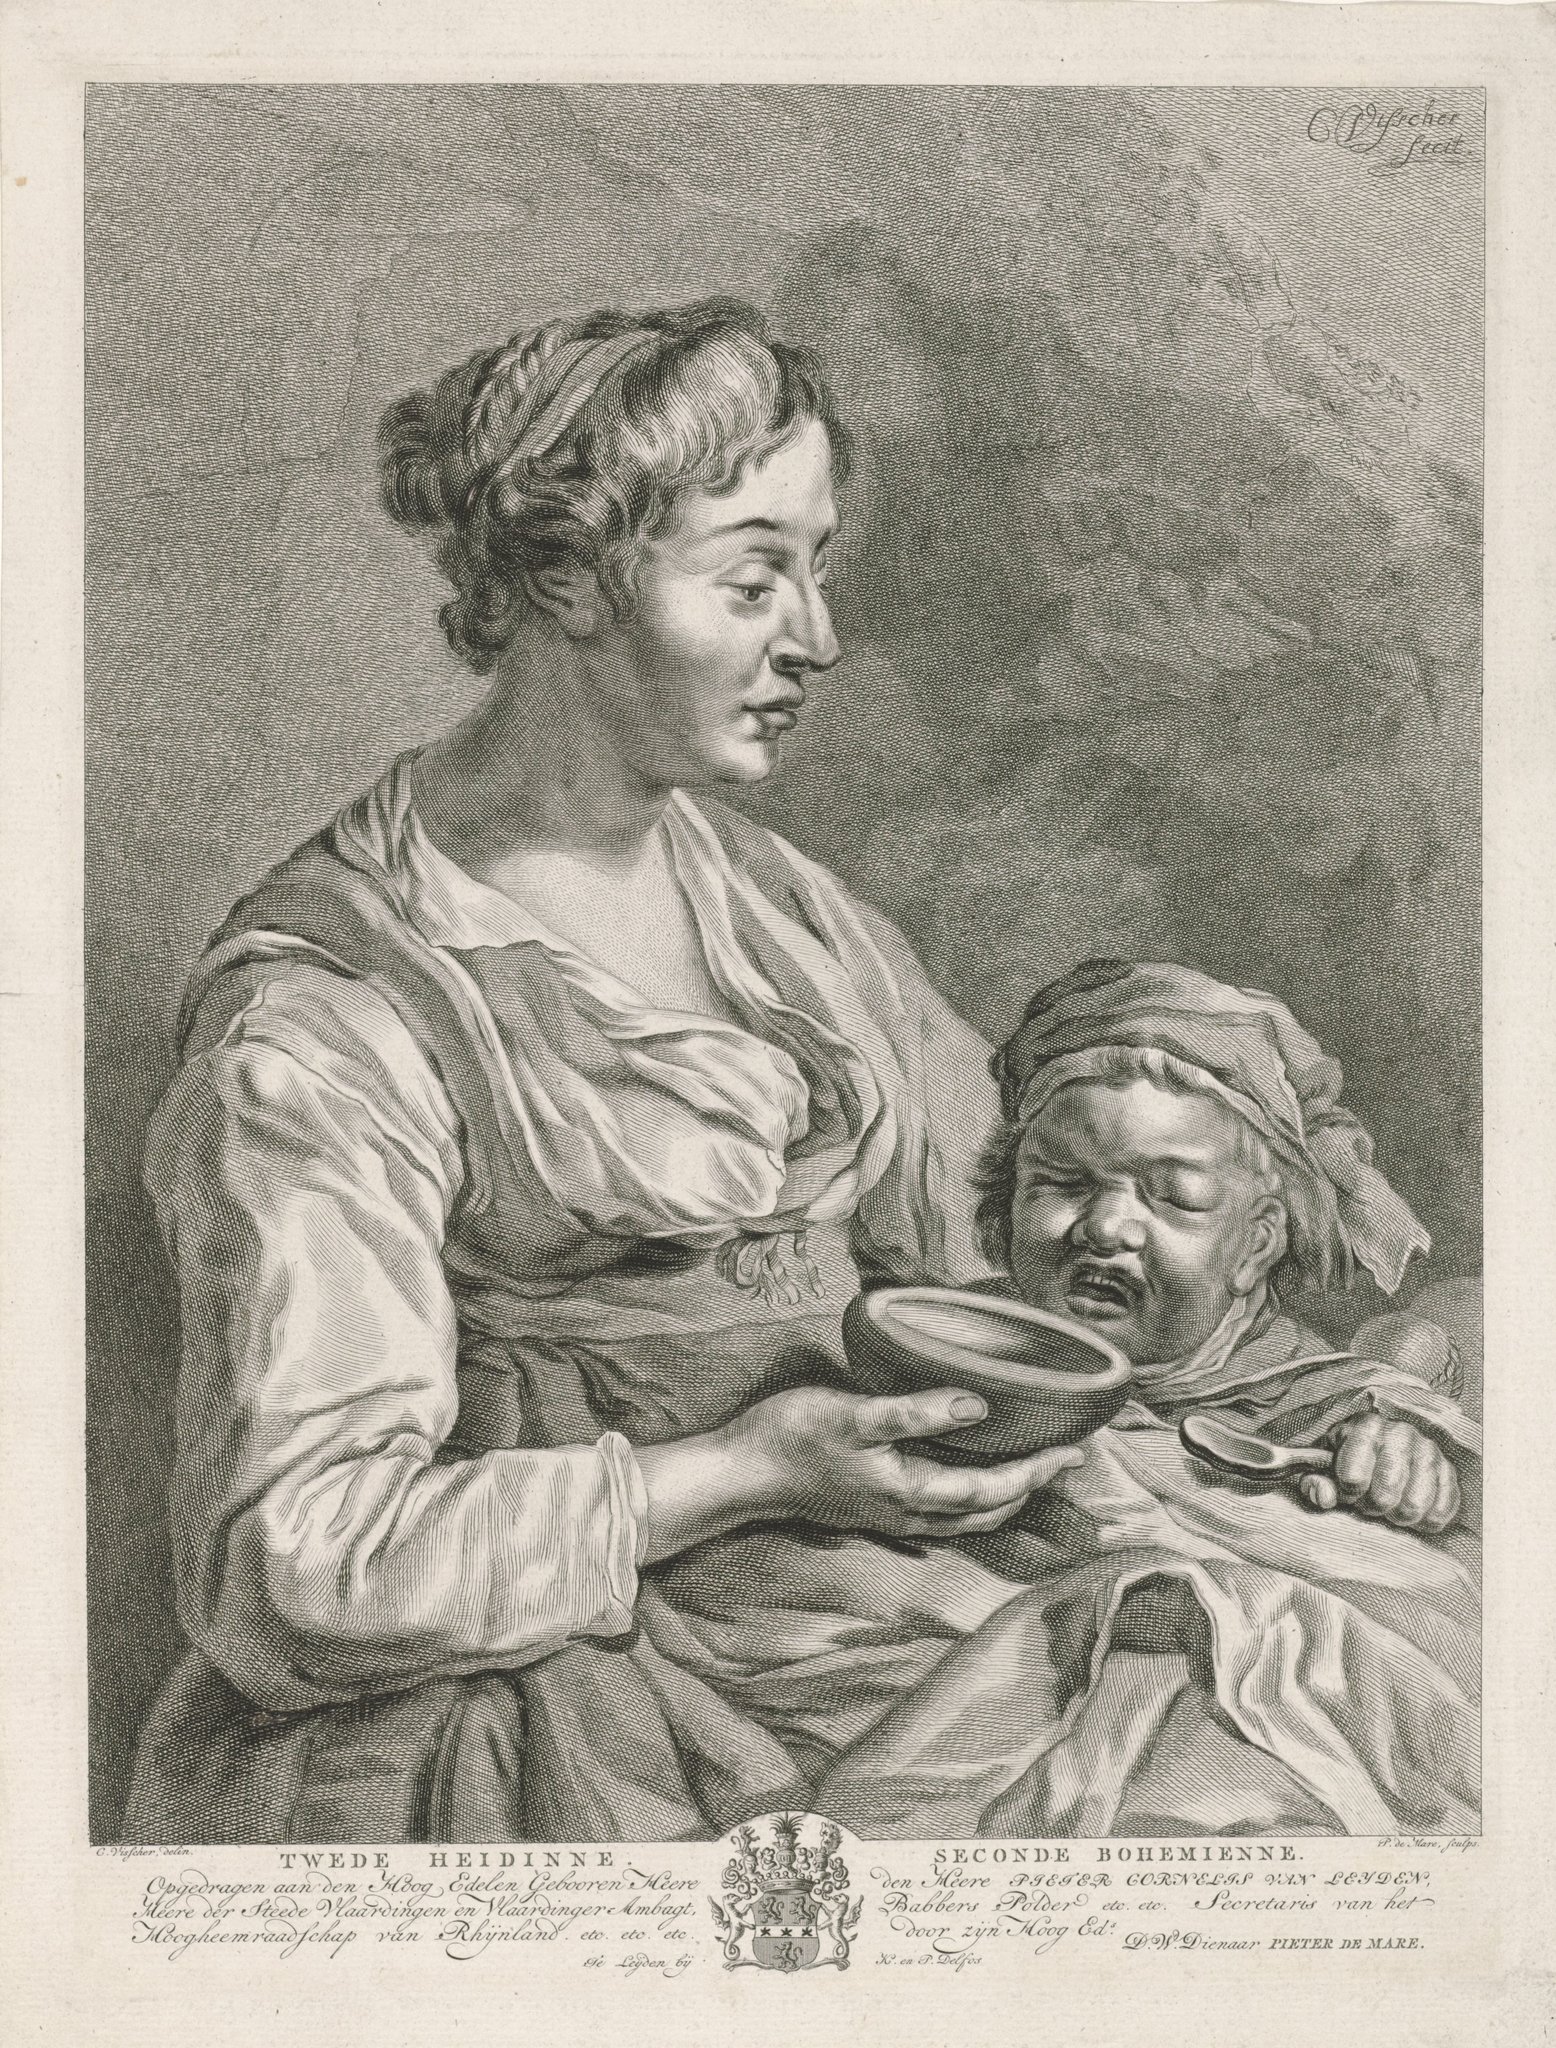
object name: print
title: Twede Heidinne / Seconde Bohemienne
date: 1786-1796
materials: paper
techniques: engraving, etching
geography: leiden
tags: wandering communities: romani or roma, feeding a baby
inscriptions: collector's mark: Lugt 2028, collector's mark: Lugt 2228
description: Een moeder geeft haar kind te eten. De vrouw is in de titel aangeduid als behorend tot de ‘heidens’ of ‘heidenen’, een eigentijdse benaming voor Roma.